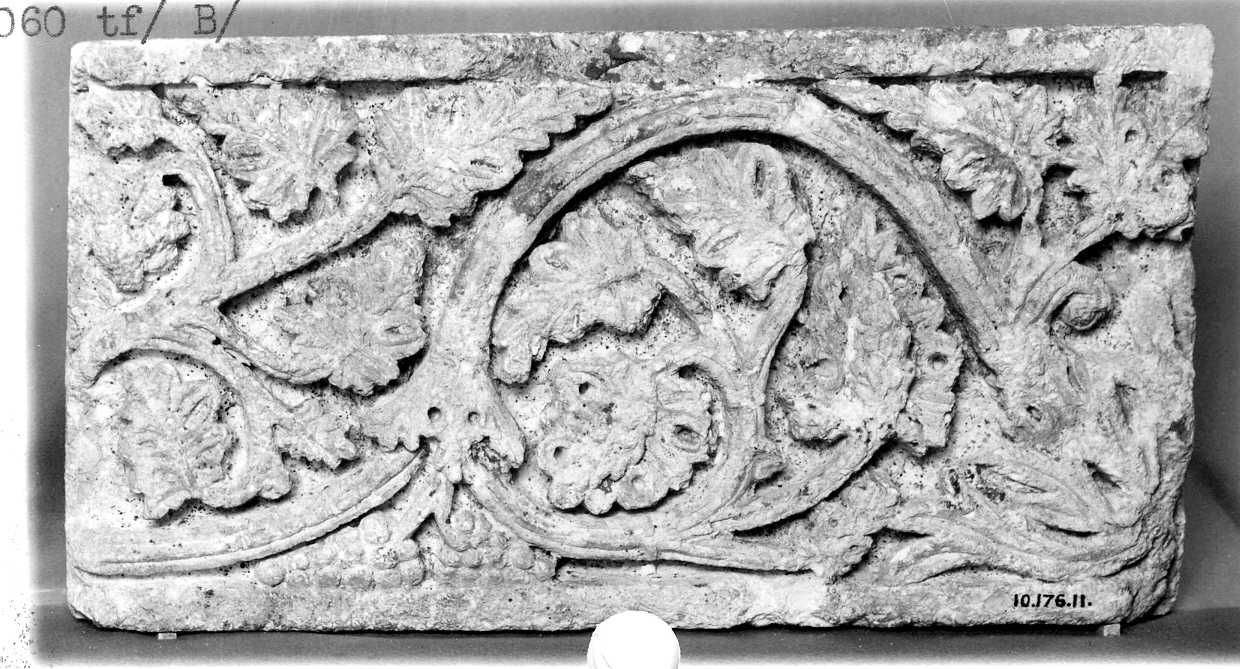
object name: fragment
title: Fragment of a Frieze with Vine Scrolls Bearing Grapes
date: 501-700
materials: limestone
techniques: carving, relief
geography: egypt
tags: vines